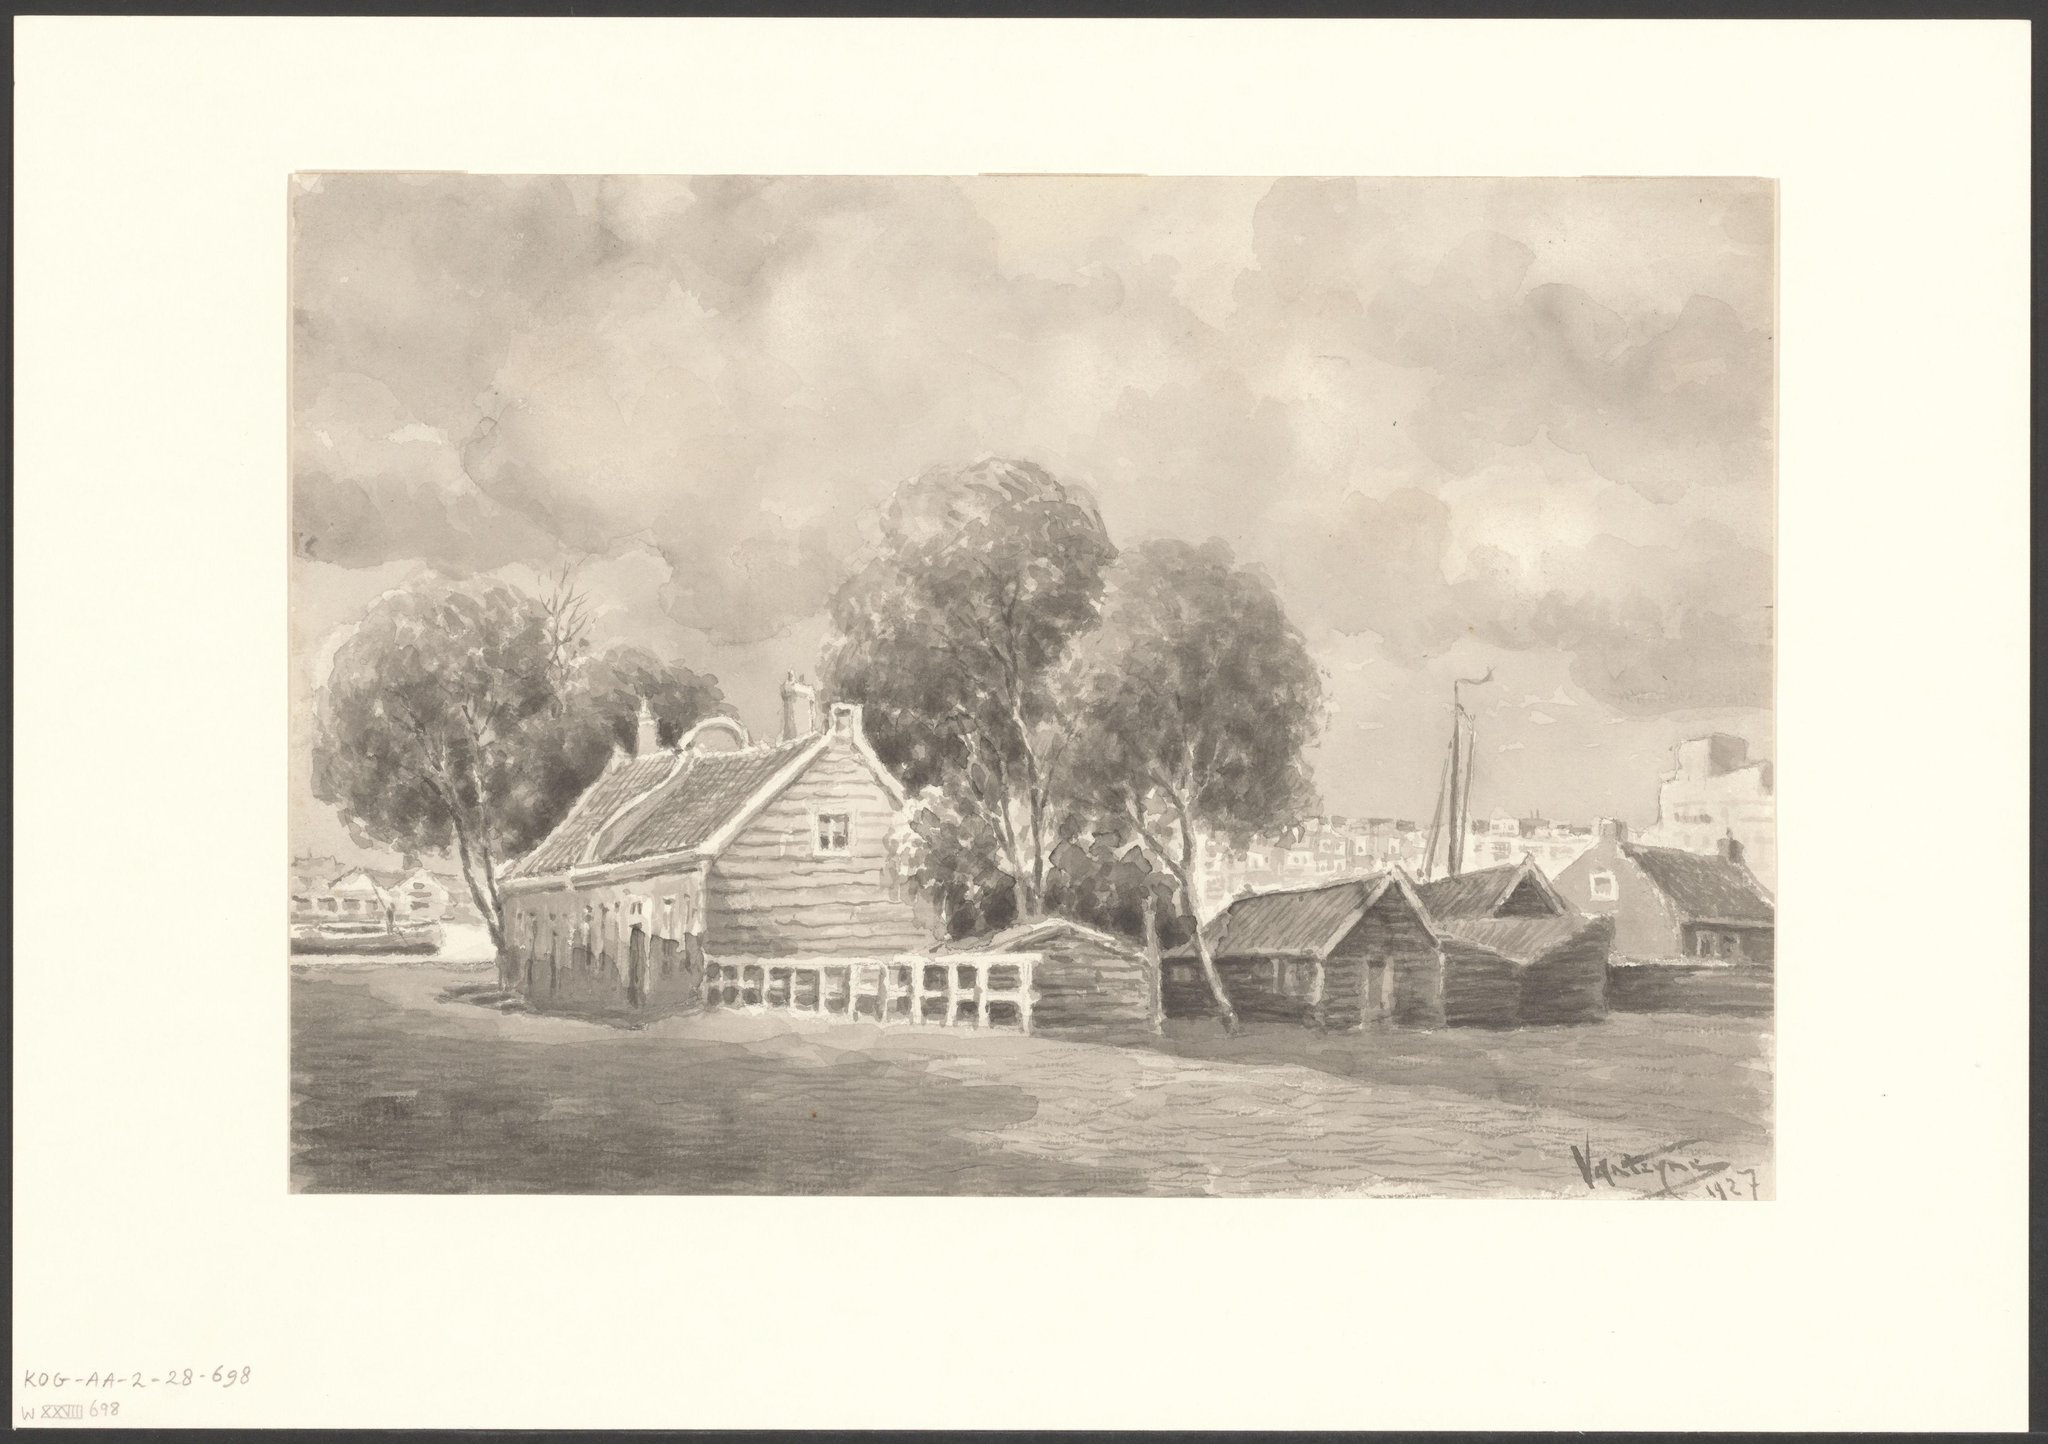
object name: drawing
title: Gezicht op de Bellamystraat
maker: anthonie van teijn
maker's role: draughtsman, painter, print maker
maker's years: 1863-1943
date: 1906-1927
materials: ink, paper, pencil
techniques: brush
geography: amsterdam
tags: city-view in general; 'veduta', street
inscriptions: inscription: ‘Bellamystraat nabij de (...) Juni 1927. / vEck’, collector's mark: Lugt 800a, signature and date: ‘VanTeyne / 1927’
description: Tekening binnen de Atlas Van Eck ingedeeld op wijknummer 28.